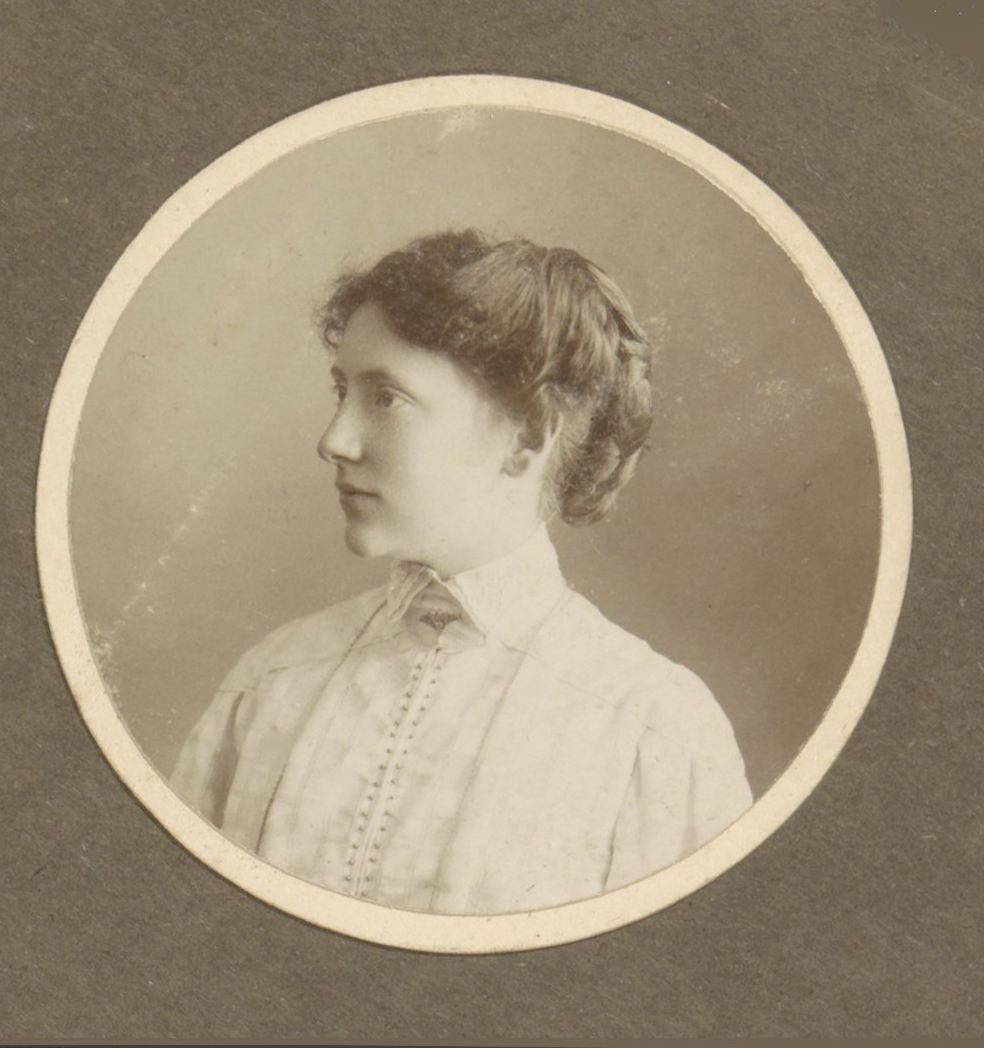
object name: photograph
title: Portret van Flop Vermeulen met opgestoken haar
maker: cornelis johannes lodewicus vermeulen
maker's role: fotograaf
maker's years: 1861-1936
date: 1900-1920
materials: paper, photographic support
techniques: gelatin silver print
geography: the hague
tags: adolescent, young woman, maiden, the hague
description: Onderdeel van Fotoalbum met opnames van het gezin en het huis van fotograaf C.J.L. Vermeulen in Den Haag.